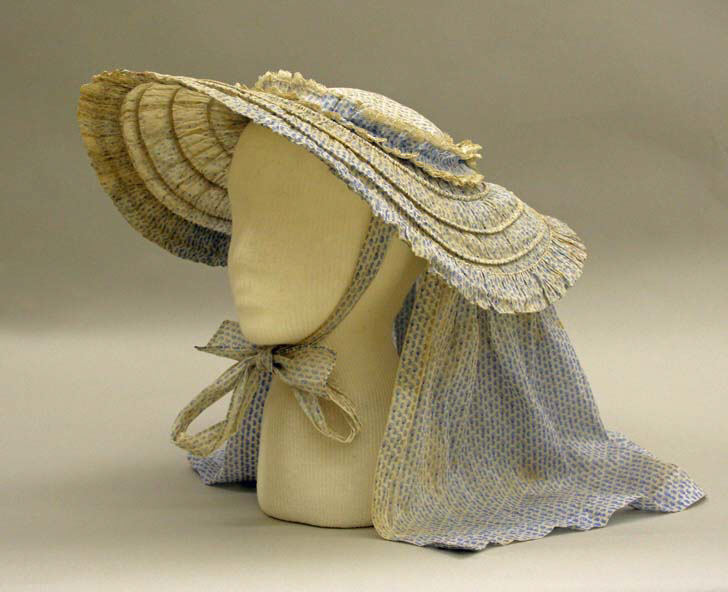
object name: sunbonnet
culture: american or european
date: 1834-1866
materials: cotton, metal